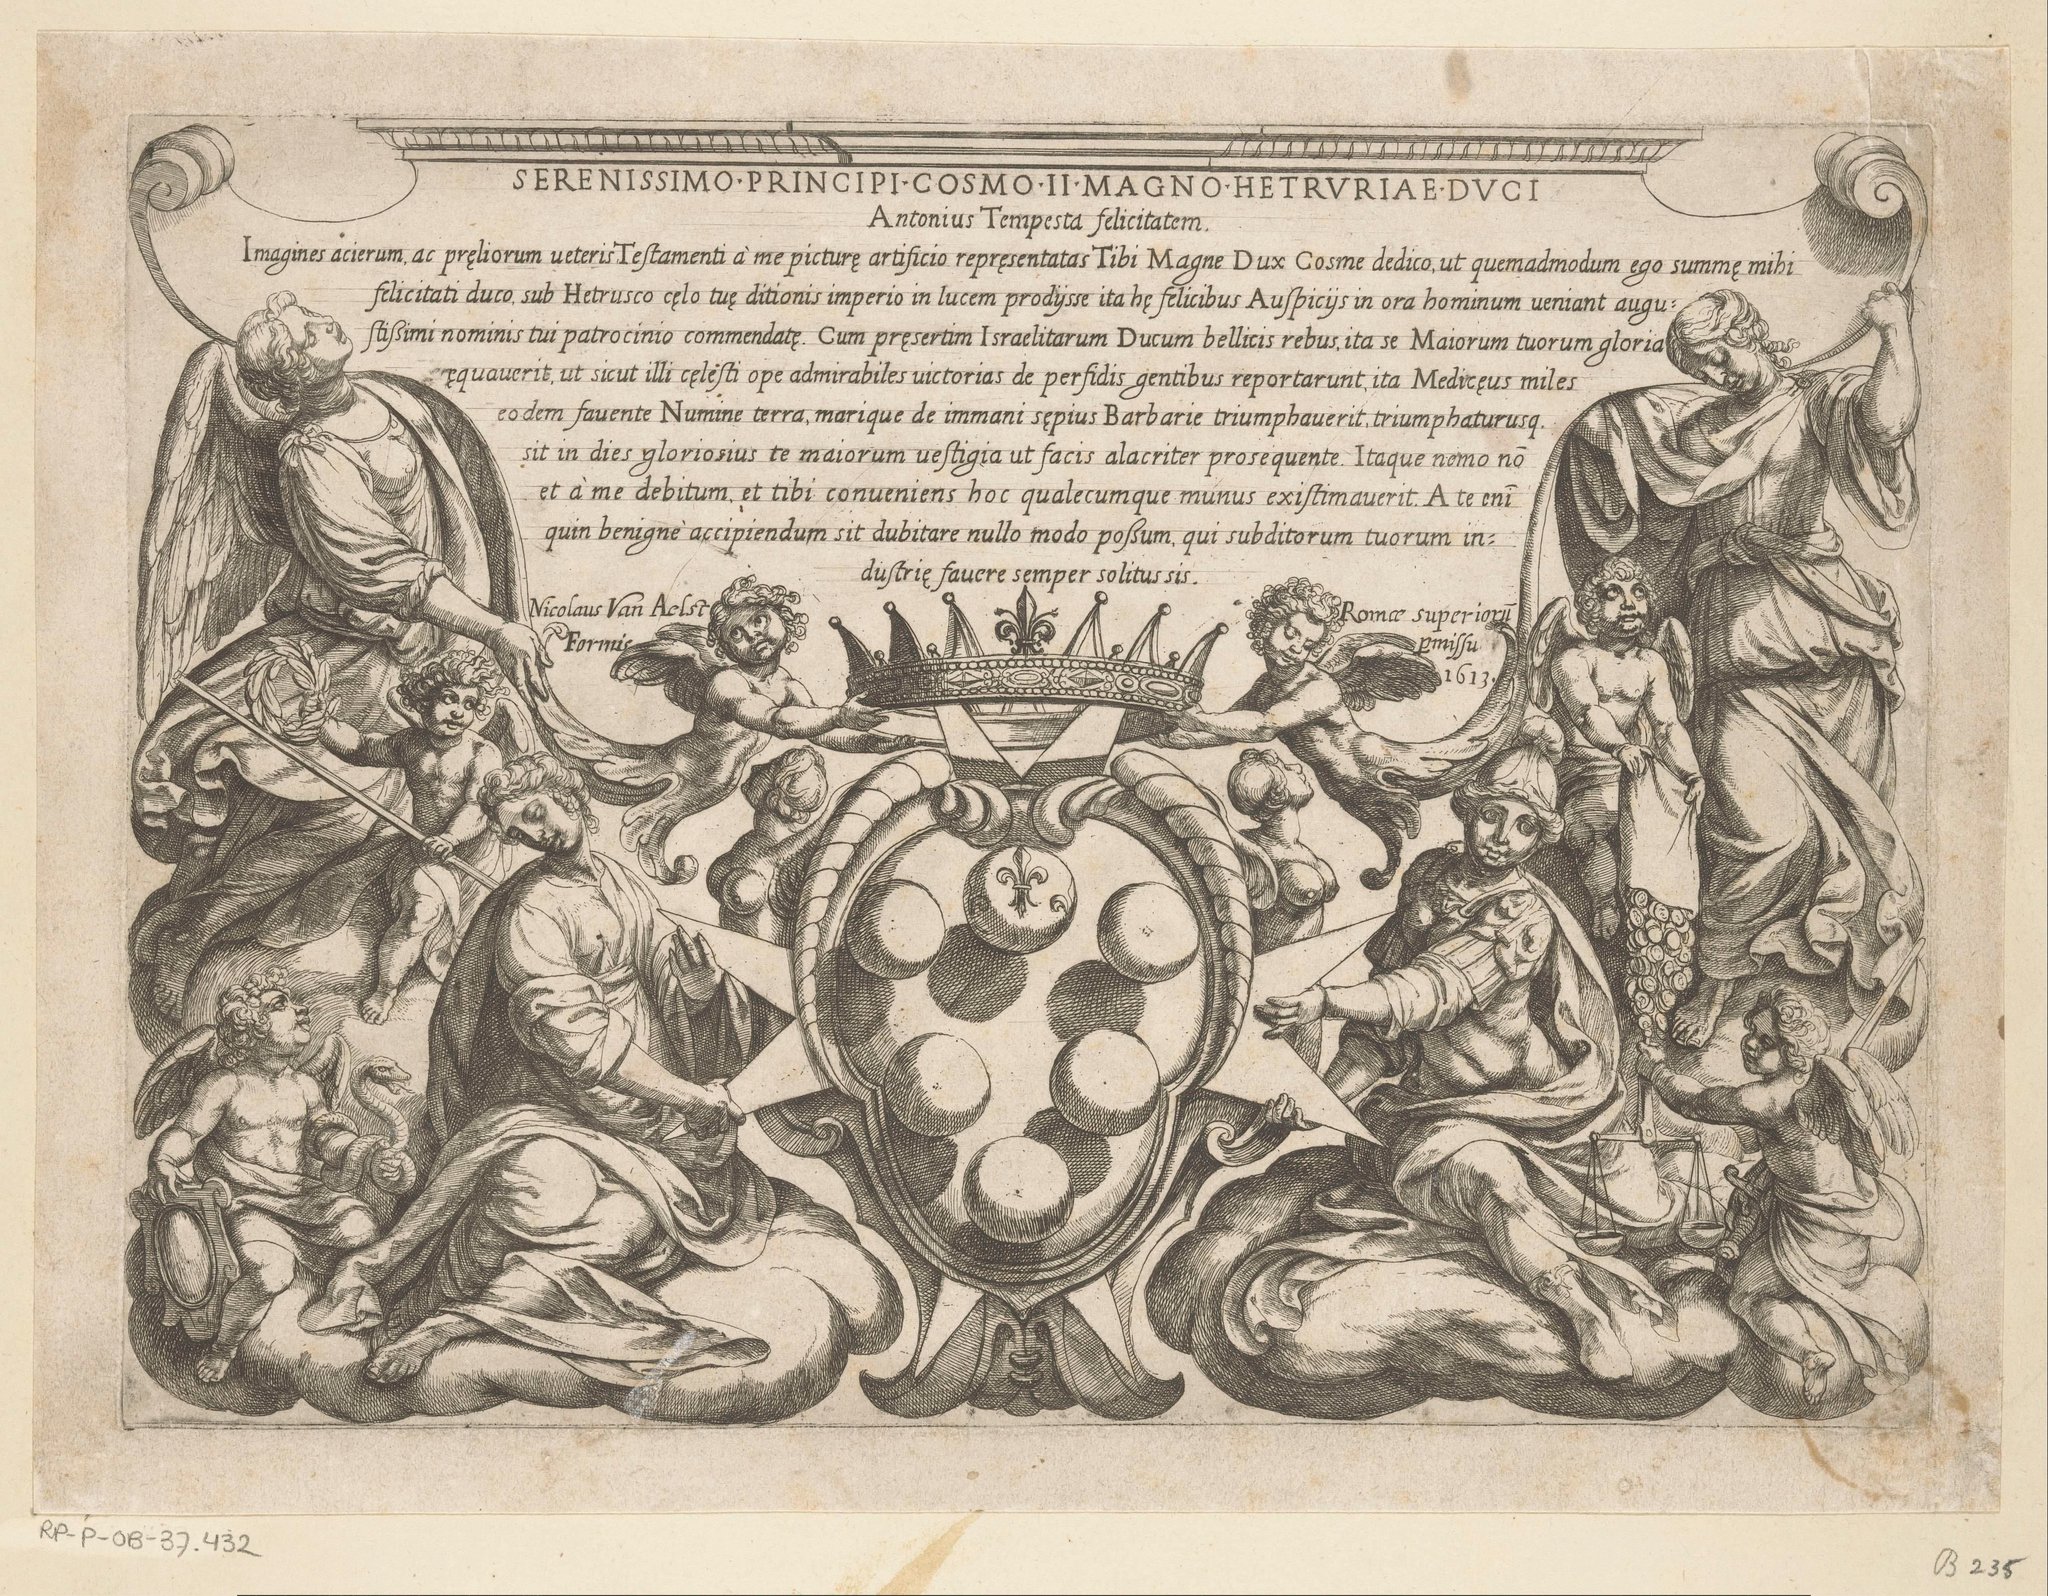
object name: titelprent, frontispice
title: Oudtestamentische strijdscènes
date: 1613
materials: paper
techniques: etching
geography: italy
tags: coat of arms (symbol of sovereignty), justitia (justice) as roman personification, fama as roman personification, generosity, liberality; 'generosità', 'liberalità' (ripa), cupids: 'amores', 'amoretti', 'putti', prudentia (prudence) as roman personification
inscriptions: collector's mark: Lugt 240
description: Titelprent bij een reeks van 24 prenten met oudtestamentische strijdscènes.